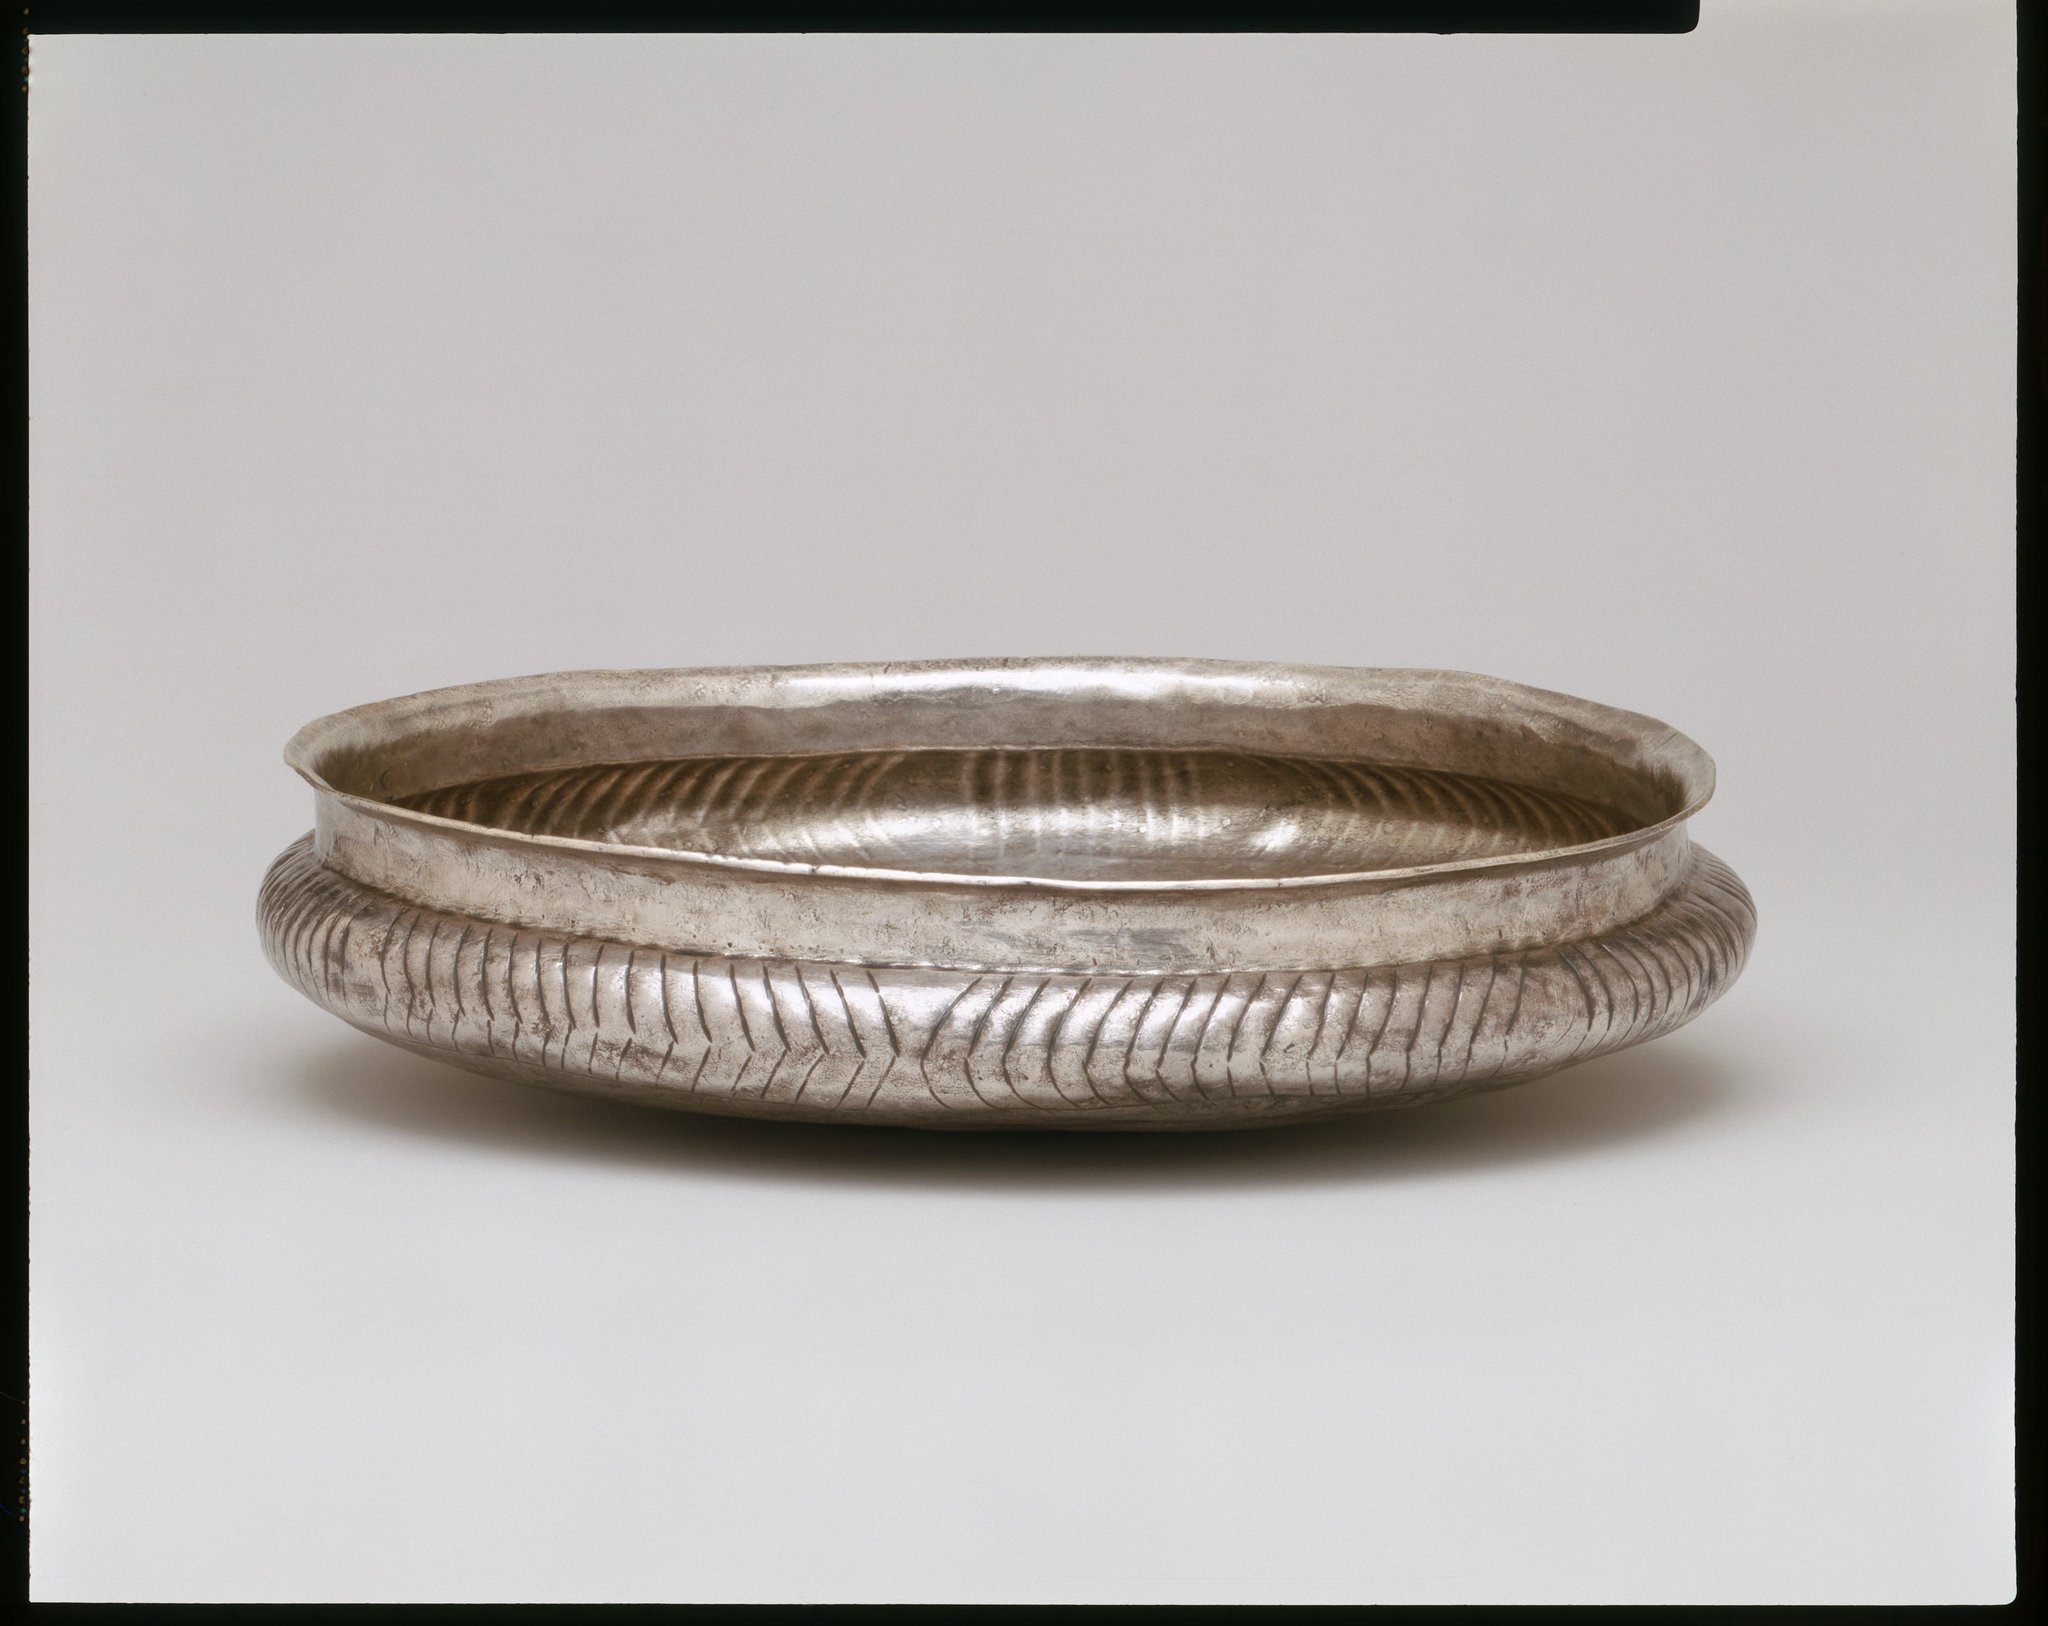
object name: bowl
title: Silver bowl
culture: cycladic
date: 3200-2200 BCE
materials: silver